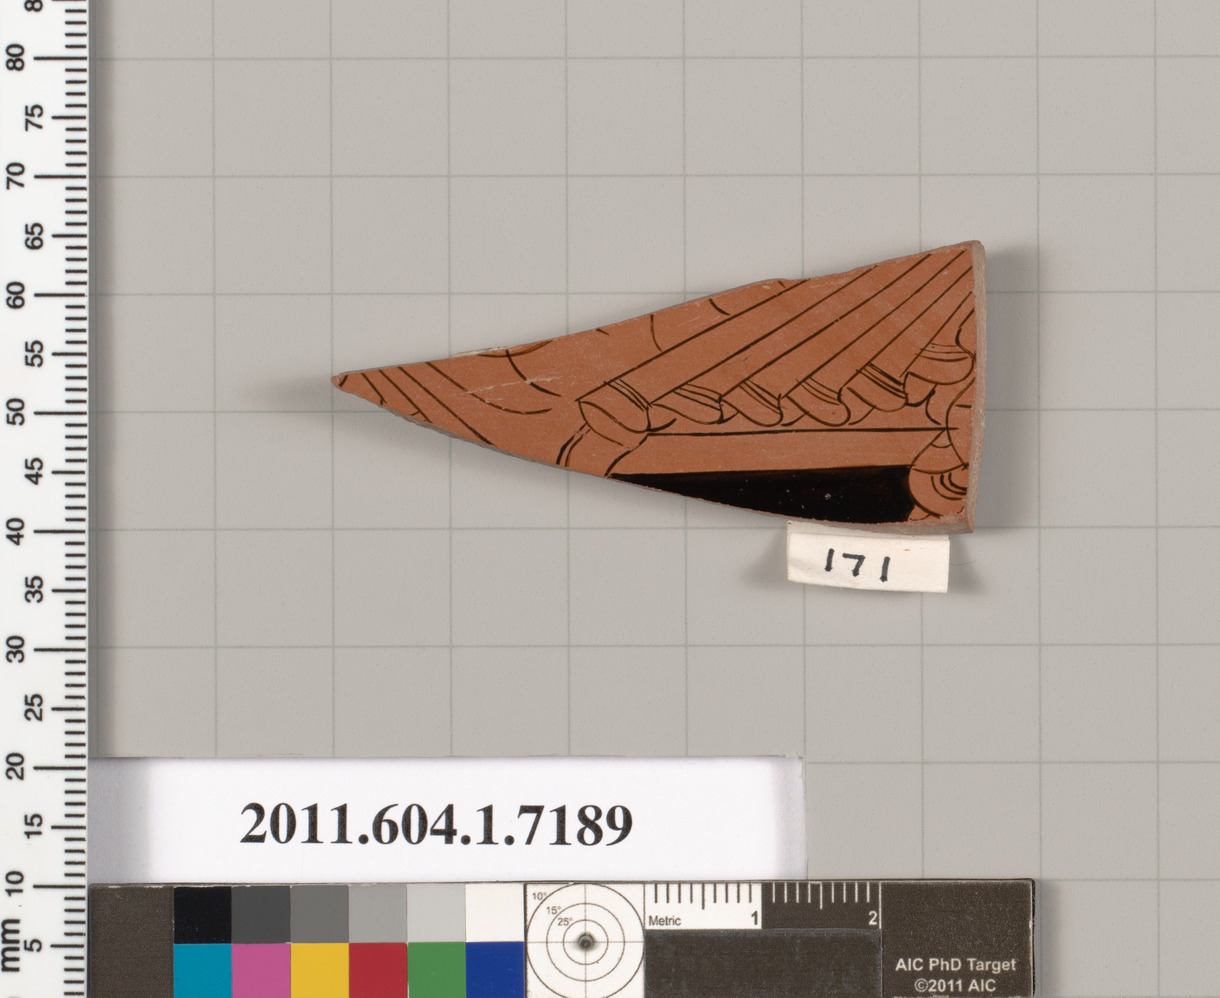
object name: kylix fragment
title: Terracotta fragment of a kylix (drinking cup)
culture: greek, attic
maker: makron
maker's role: artist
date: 500-480 BCE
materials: terracotta